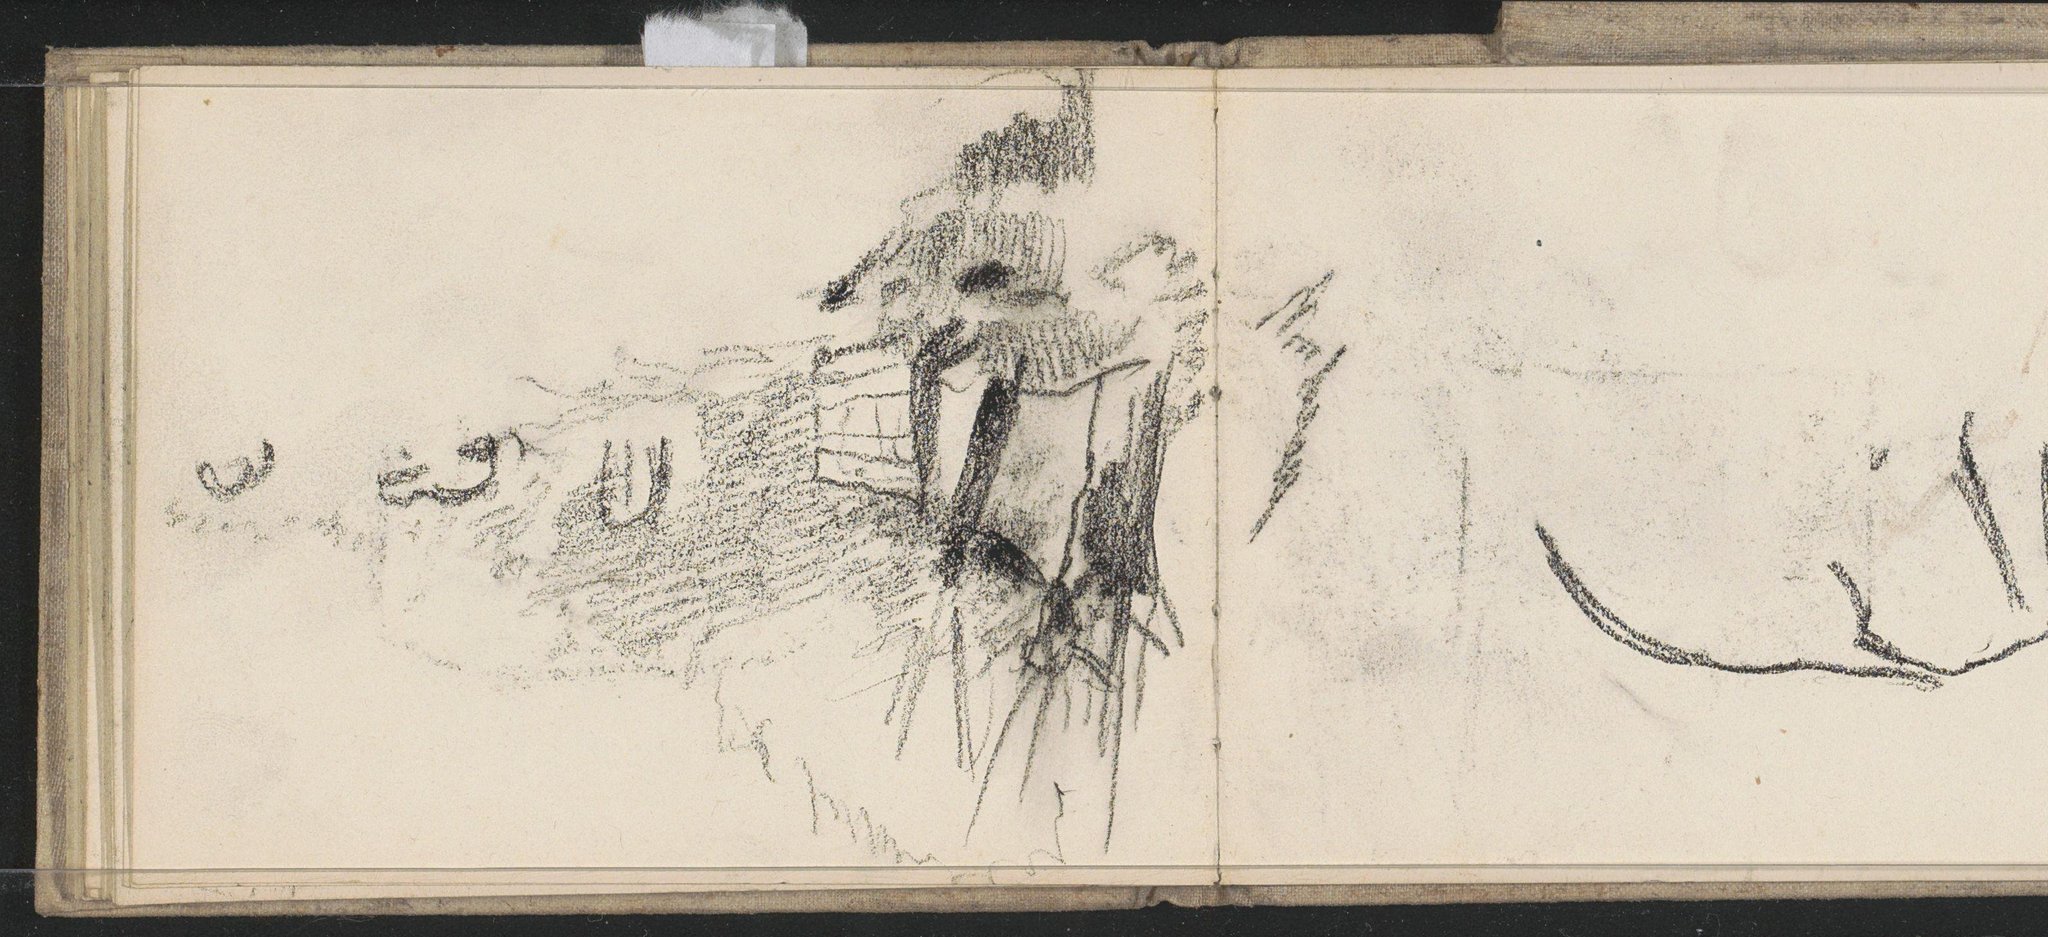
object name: sketchbook leaf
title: Studieblad, onder andere met knotwilgen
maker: anton mauve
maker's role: draughtsman, painter, print maker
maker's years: 1838-1888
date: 1881-1888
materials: chalk, paper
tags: trees: willow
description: Blad 26 verso en 27 recto uit een schetsboek met 29 bladen.